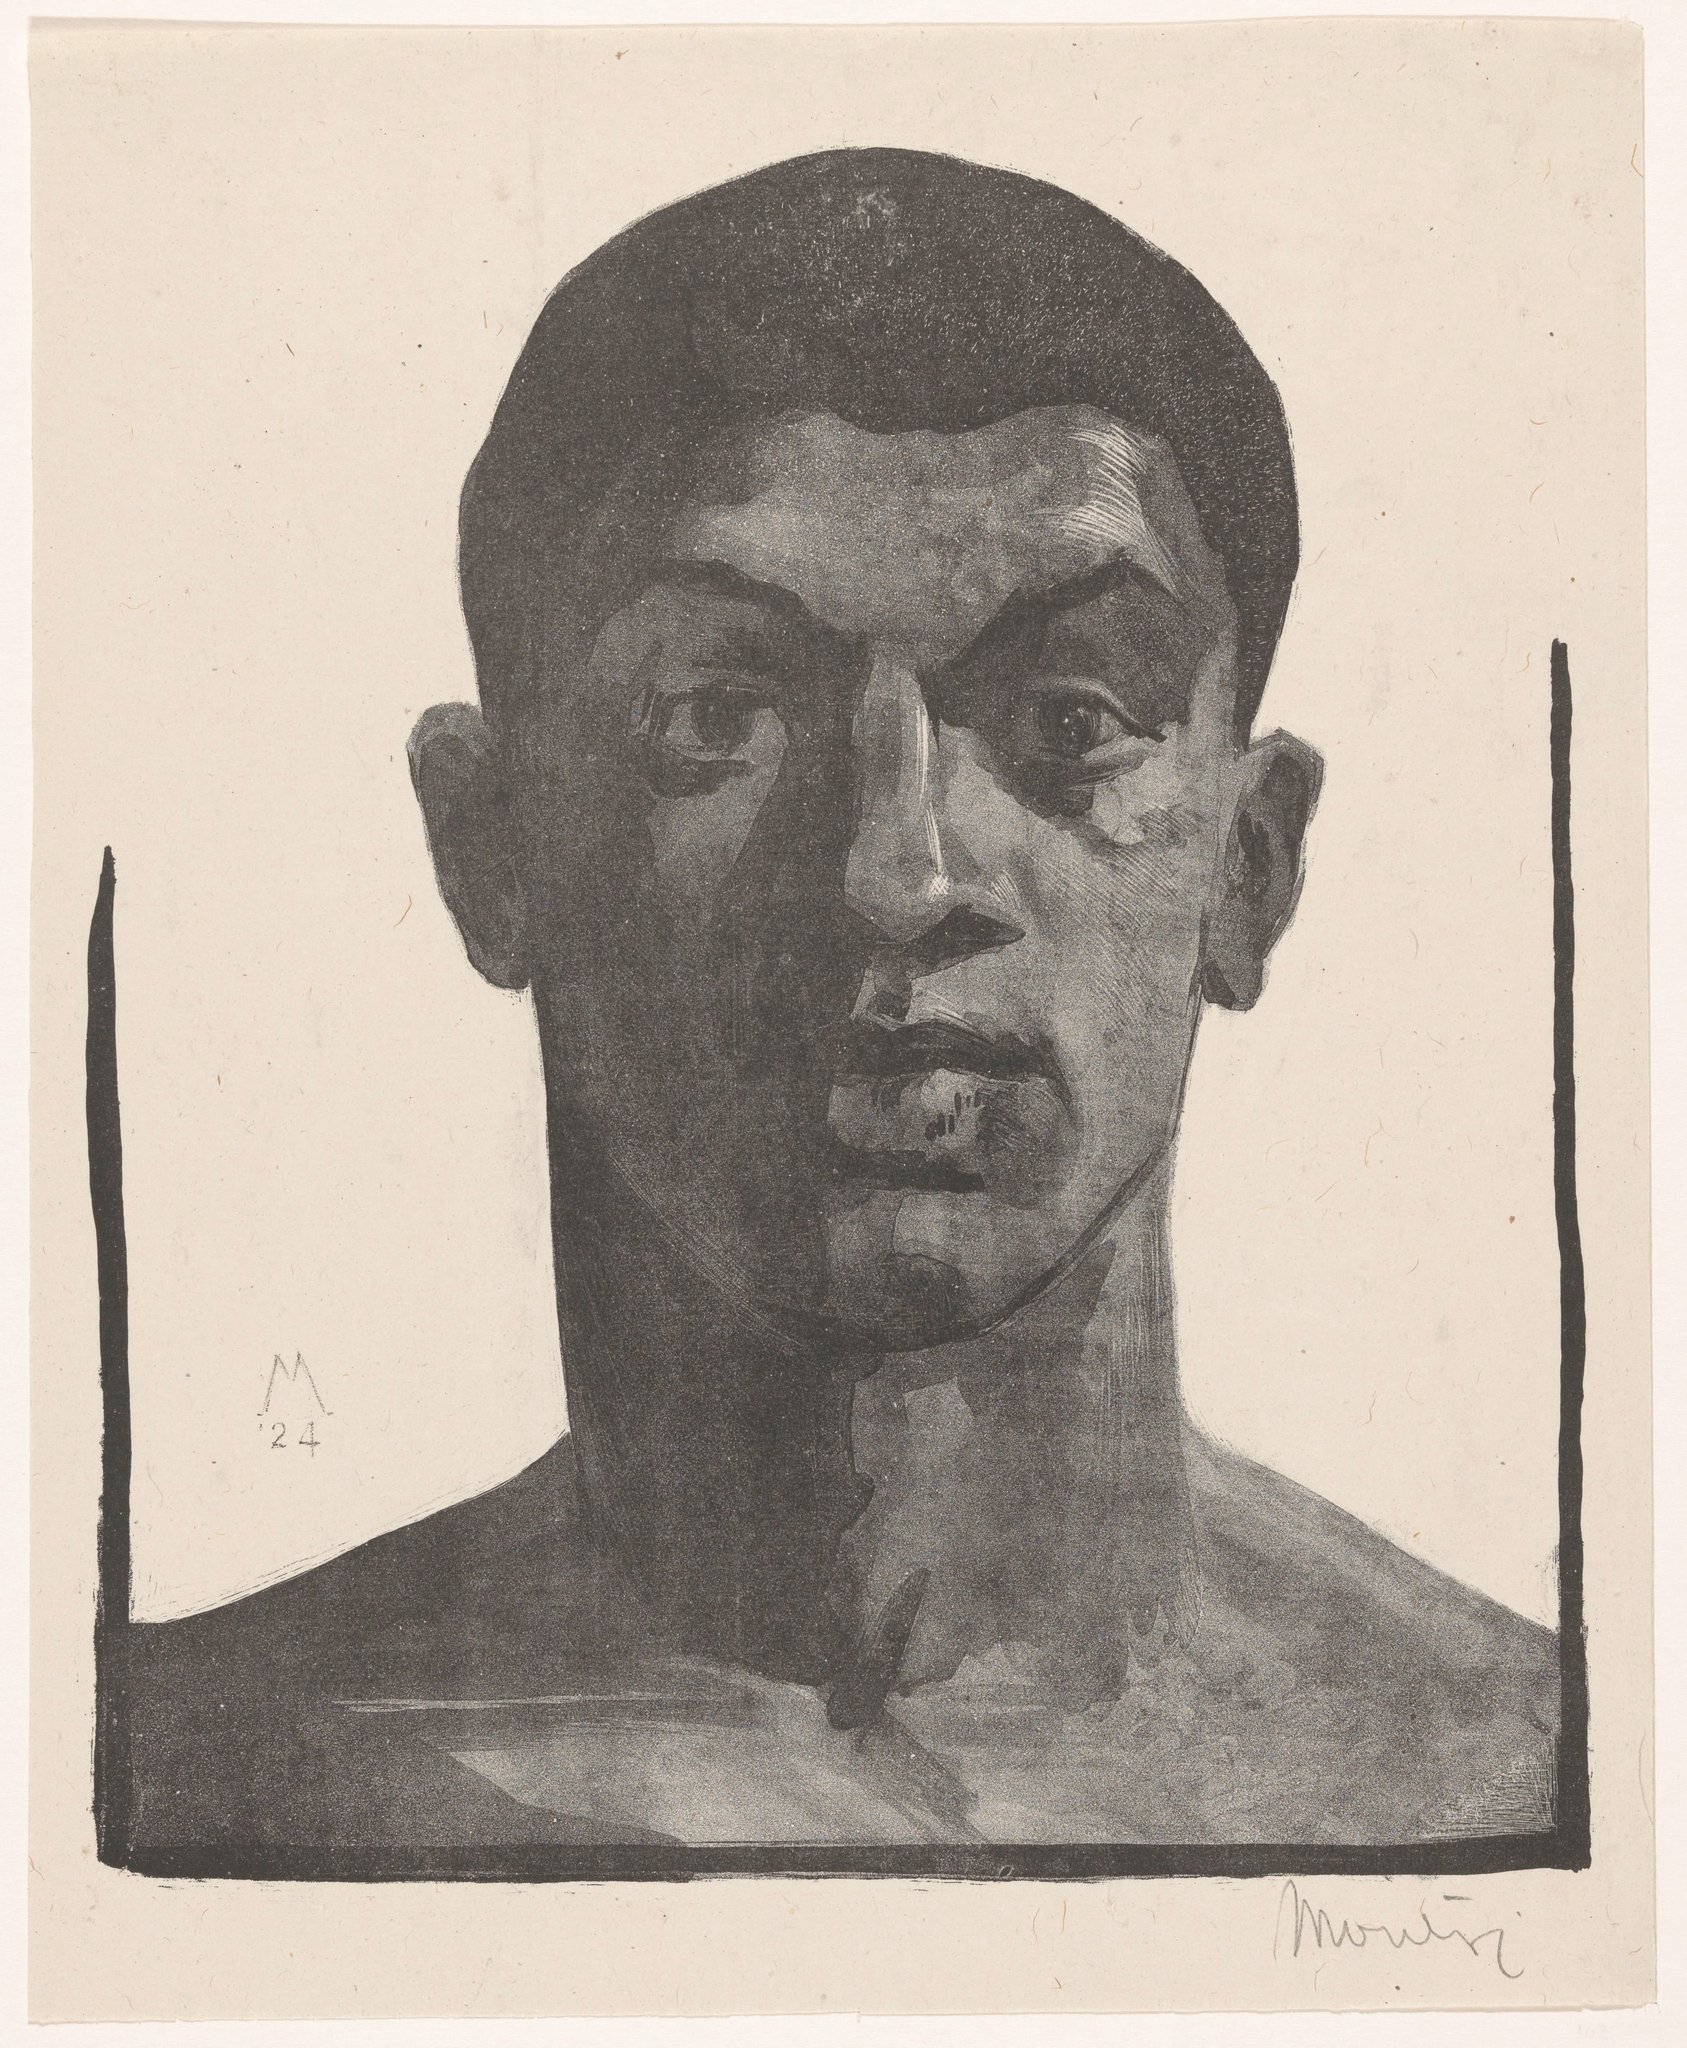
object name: print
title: Portret van een onbekende man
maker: simon moulijn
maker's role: draughtsman, print maker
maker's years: 1866-1948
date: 1924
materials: paper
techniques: lithograph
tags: africans, historical persons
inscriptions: collector's mark: Lugt 2228